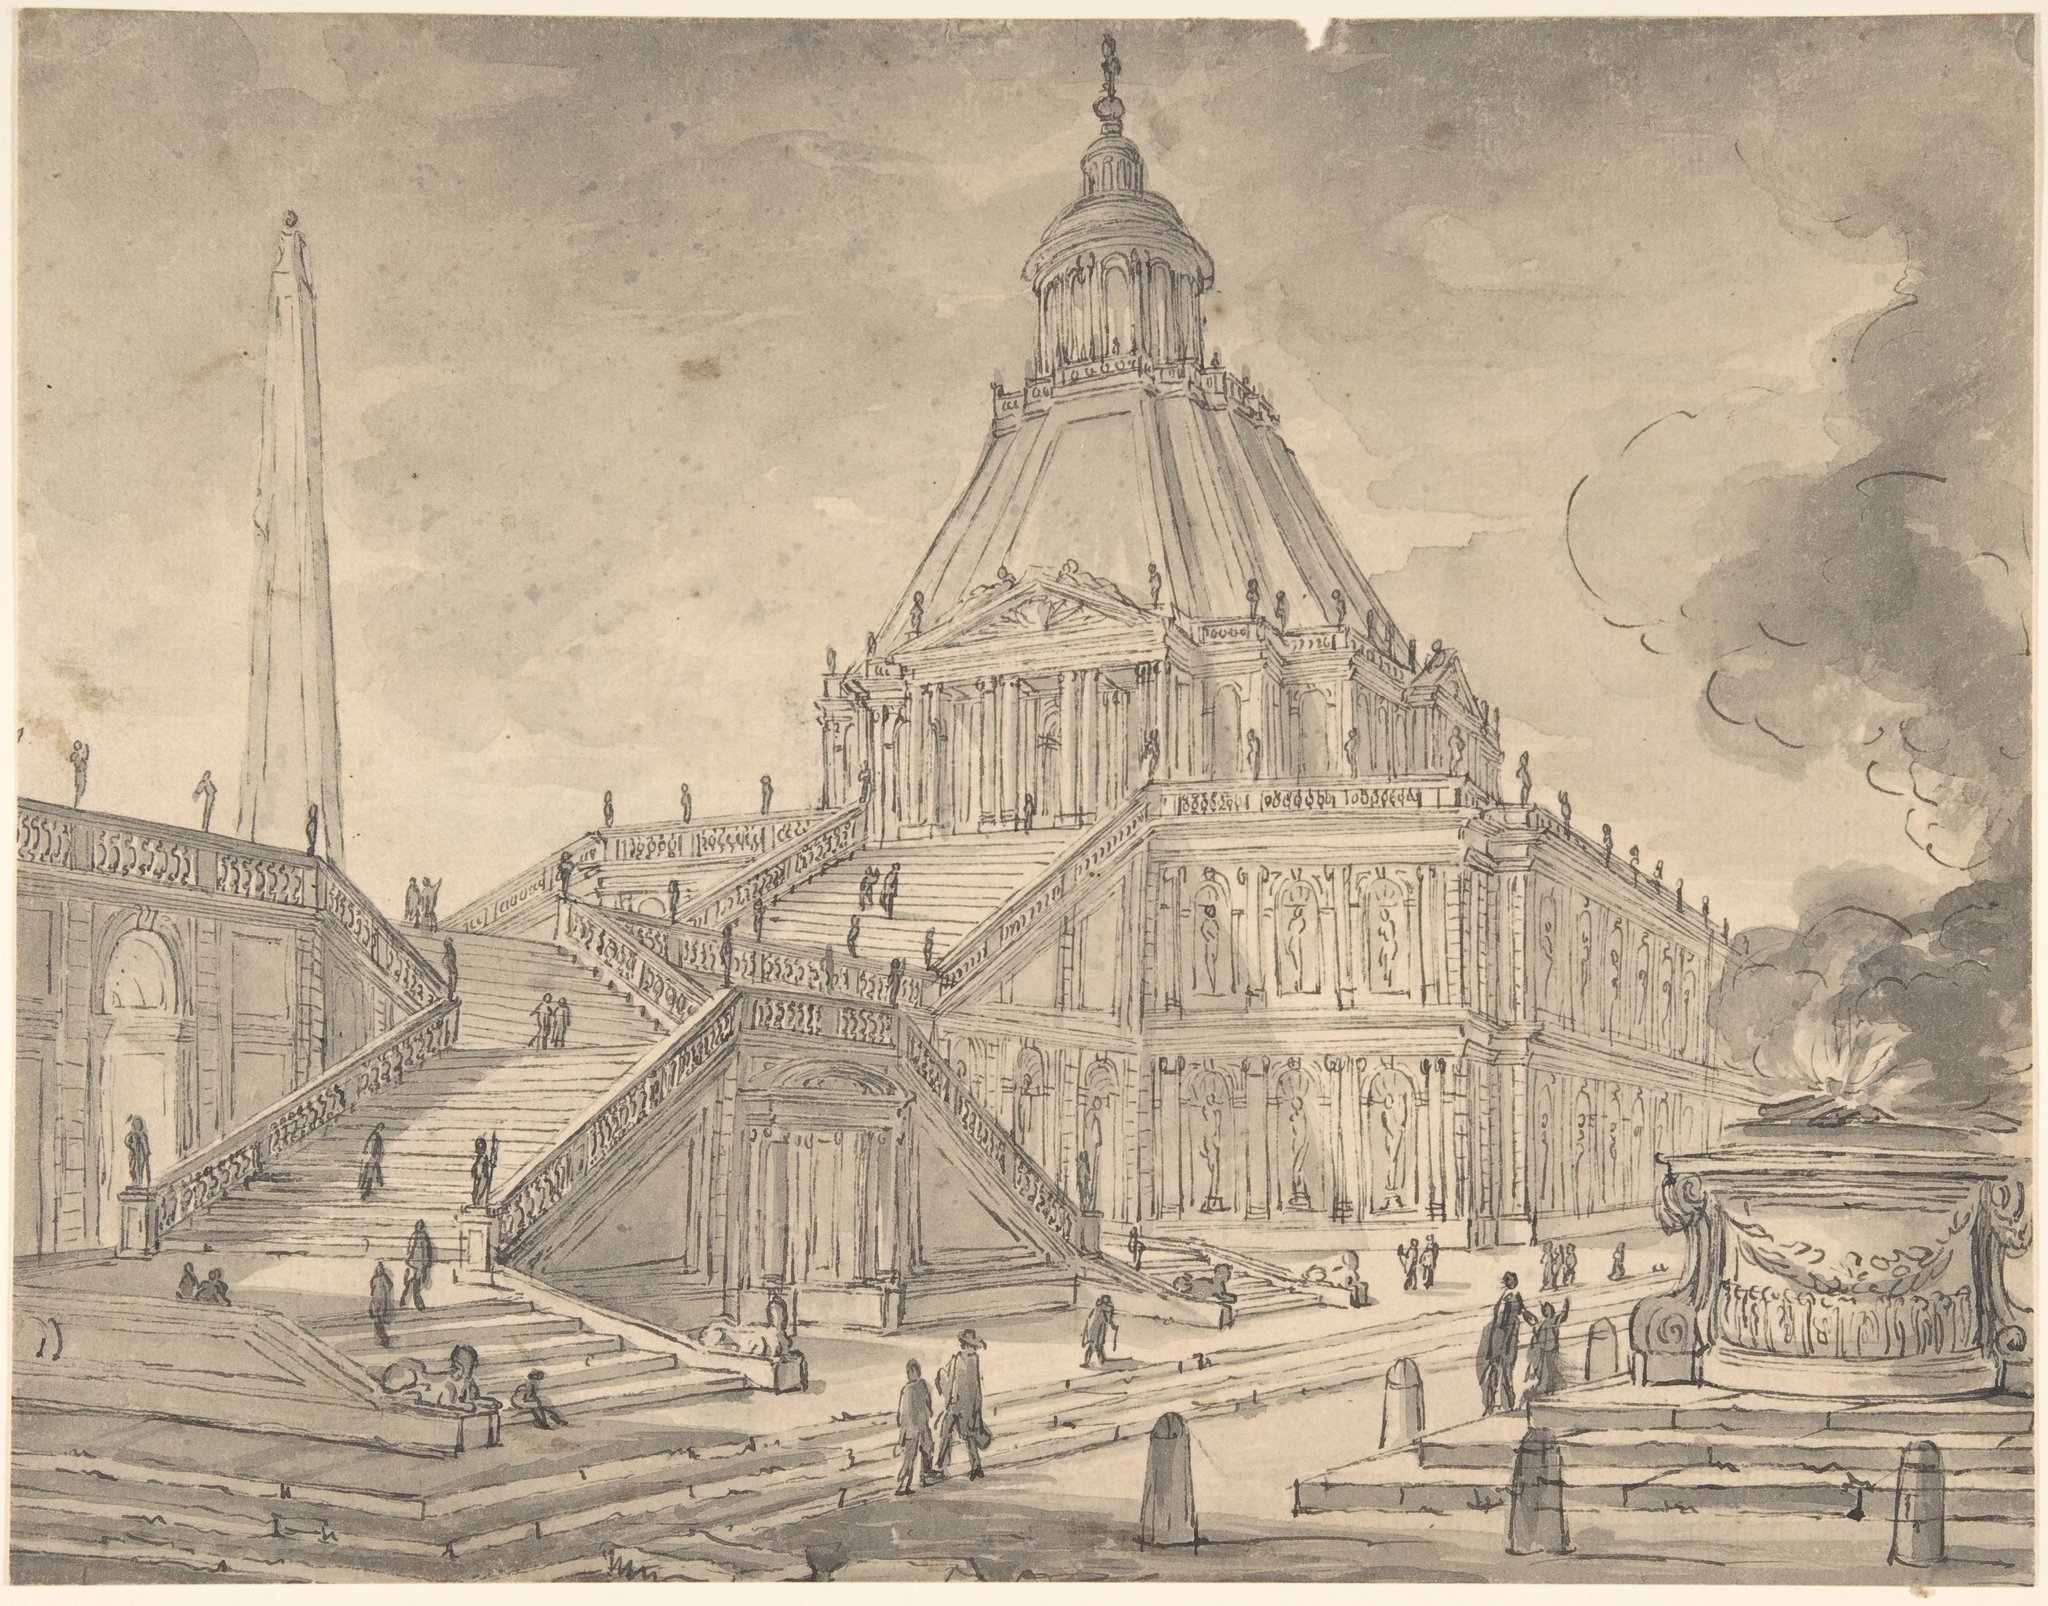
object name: drawing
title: Architectural Fantasy: Temple-like Building with Colonnades, a Monumental Staircase, and a Burnt Offering (Sacrifice) in the Foreground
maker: anonymous, italian, 18th century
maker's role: artist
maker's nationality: italian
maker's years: 1700-1800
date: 1701-1800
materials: graphite, ink, paper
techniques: brush, pen, wash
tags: architecture,buildings